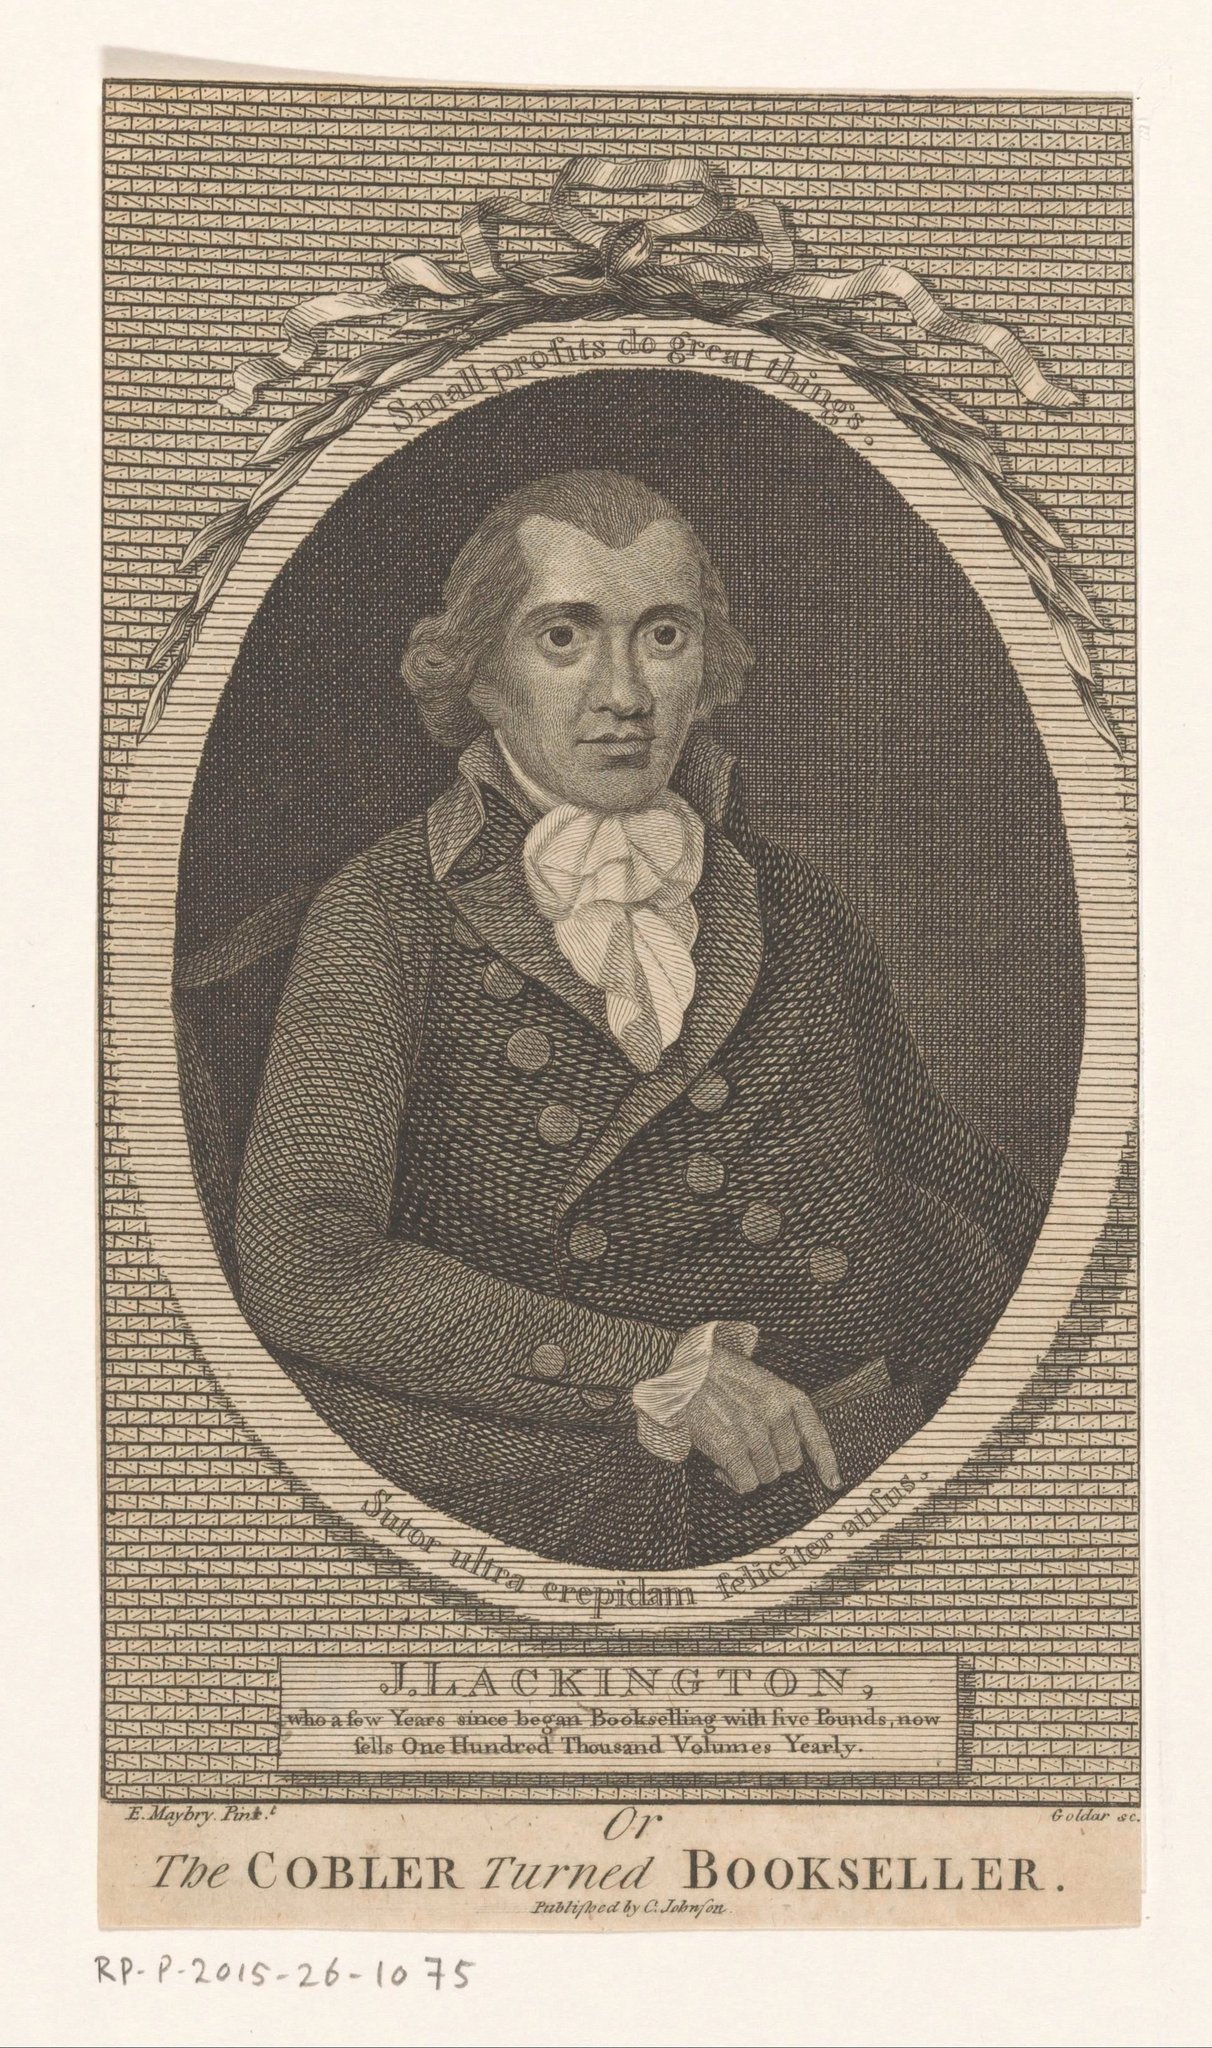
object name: print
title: J. Lackington, who a few years since began Bookselling with five Pounds, now sells One Hundred Thousand Volumes Yearly. Or the Cobler turned bookseller.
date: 1790-1795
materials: paper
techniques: engraving, etching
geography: london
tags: book-shop, bookseller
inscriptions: collector's mark: Lugt 2228, collector's mark: Lugt 4779